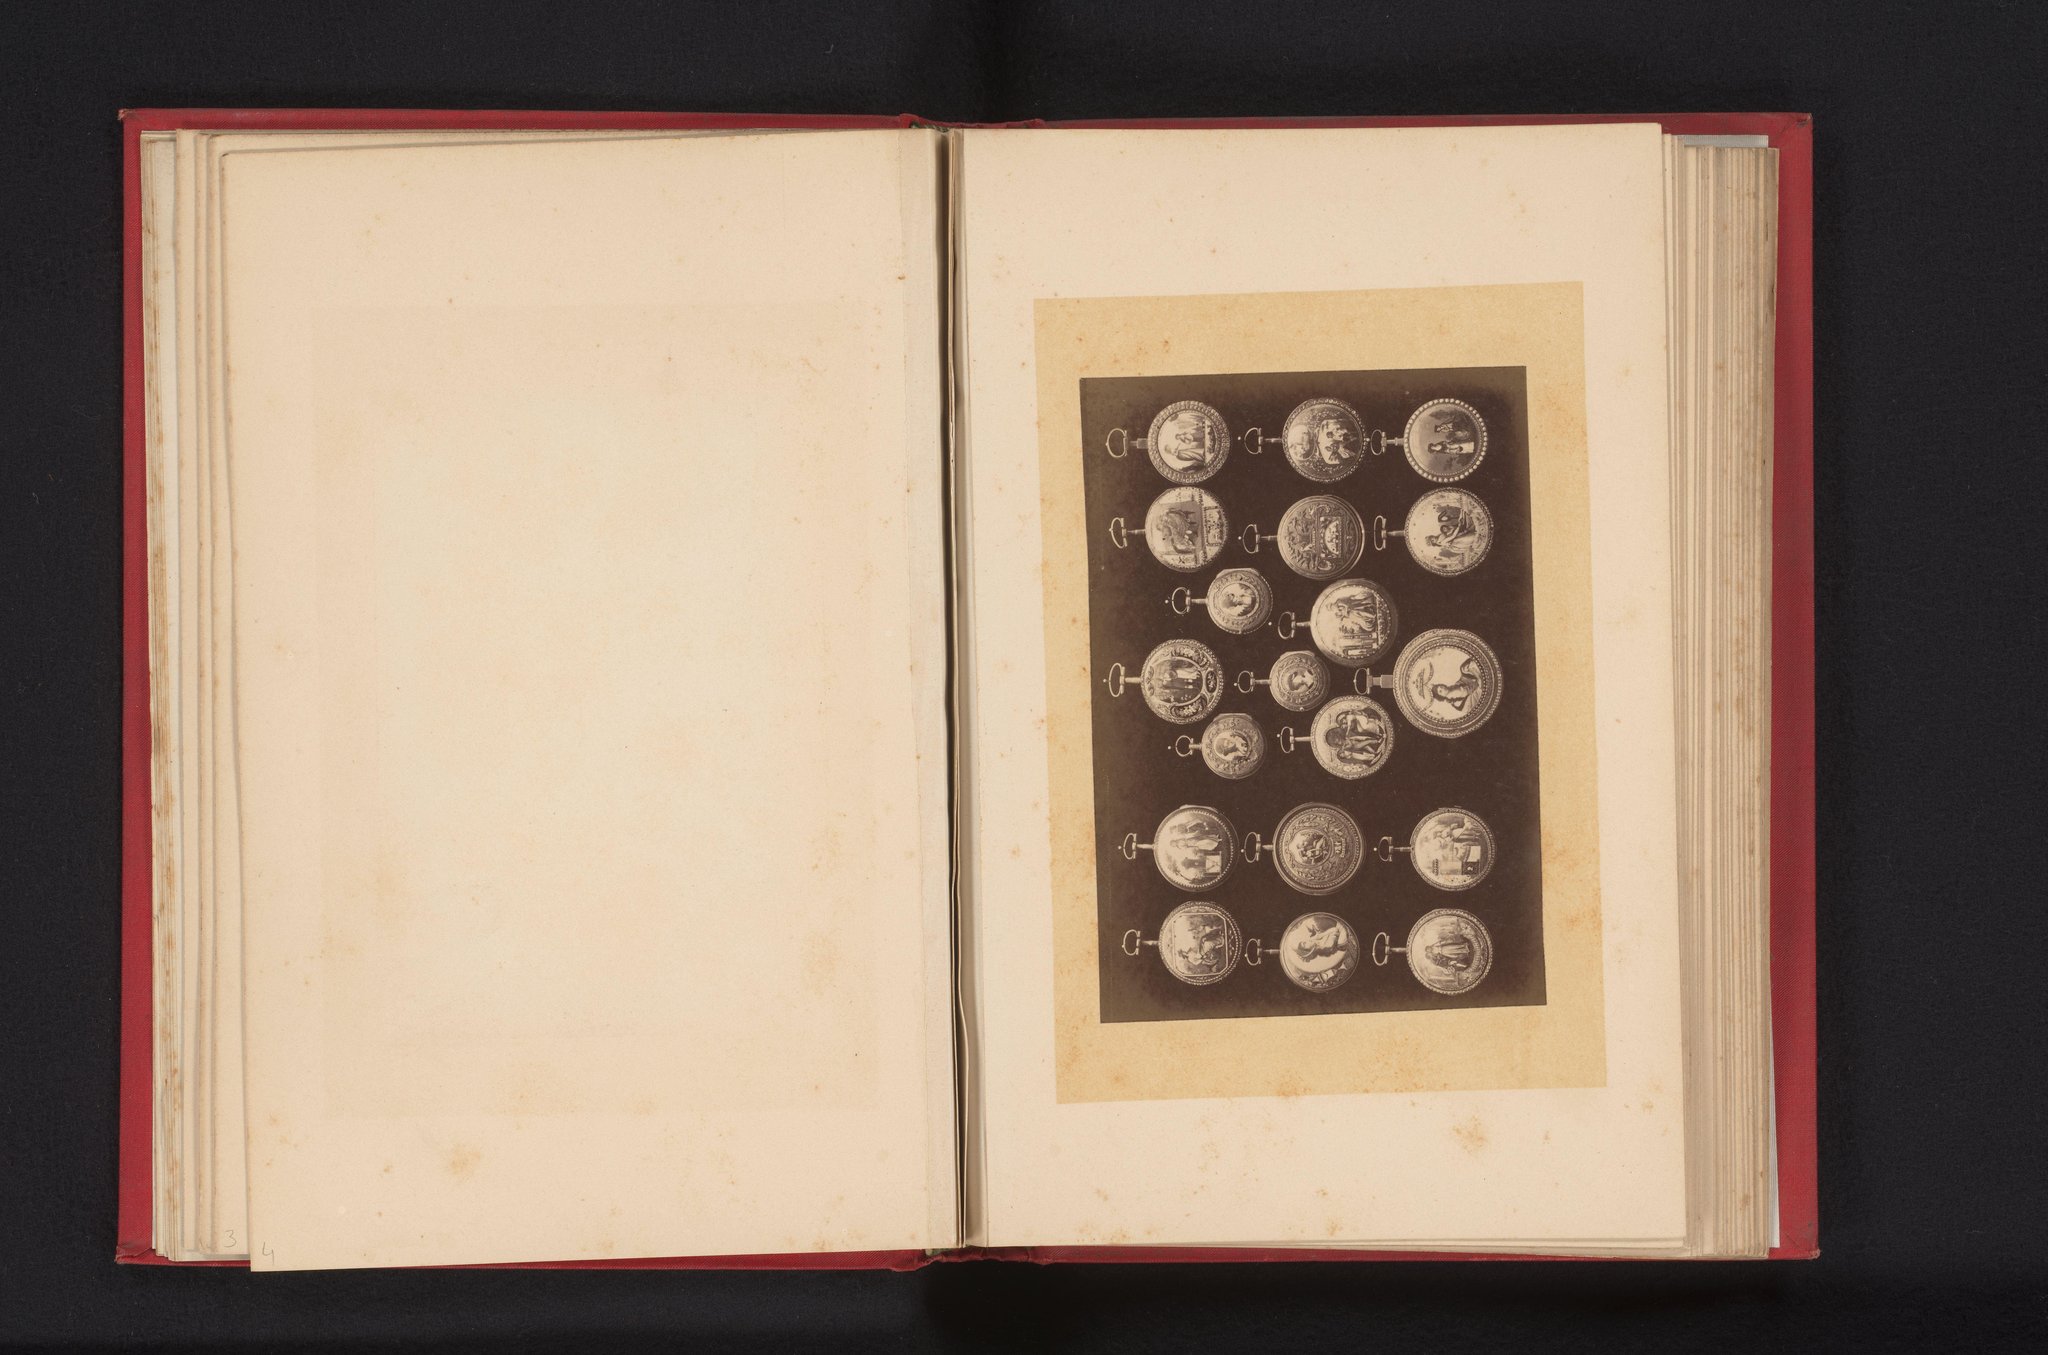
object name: photograph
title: Verschillende zakhorloges met illustraties op de kast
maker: Anonymous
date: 1872-1878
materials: photographic support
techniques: albumen print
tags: watch